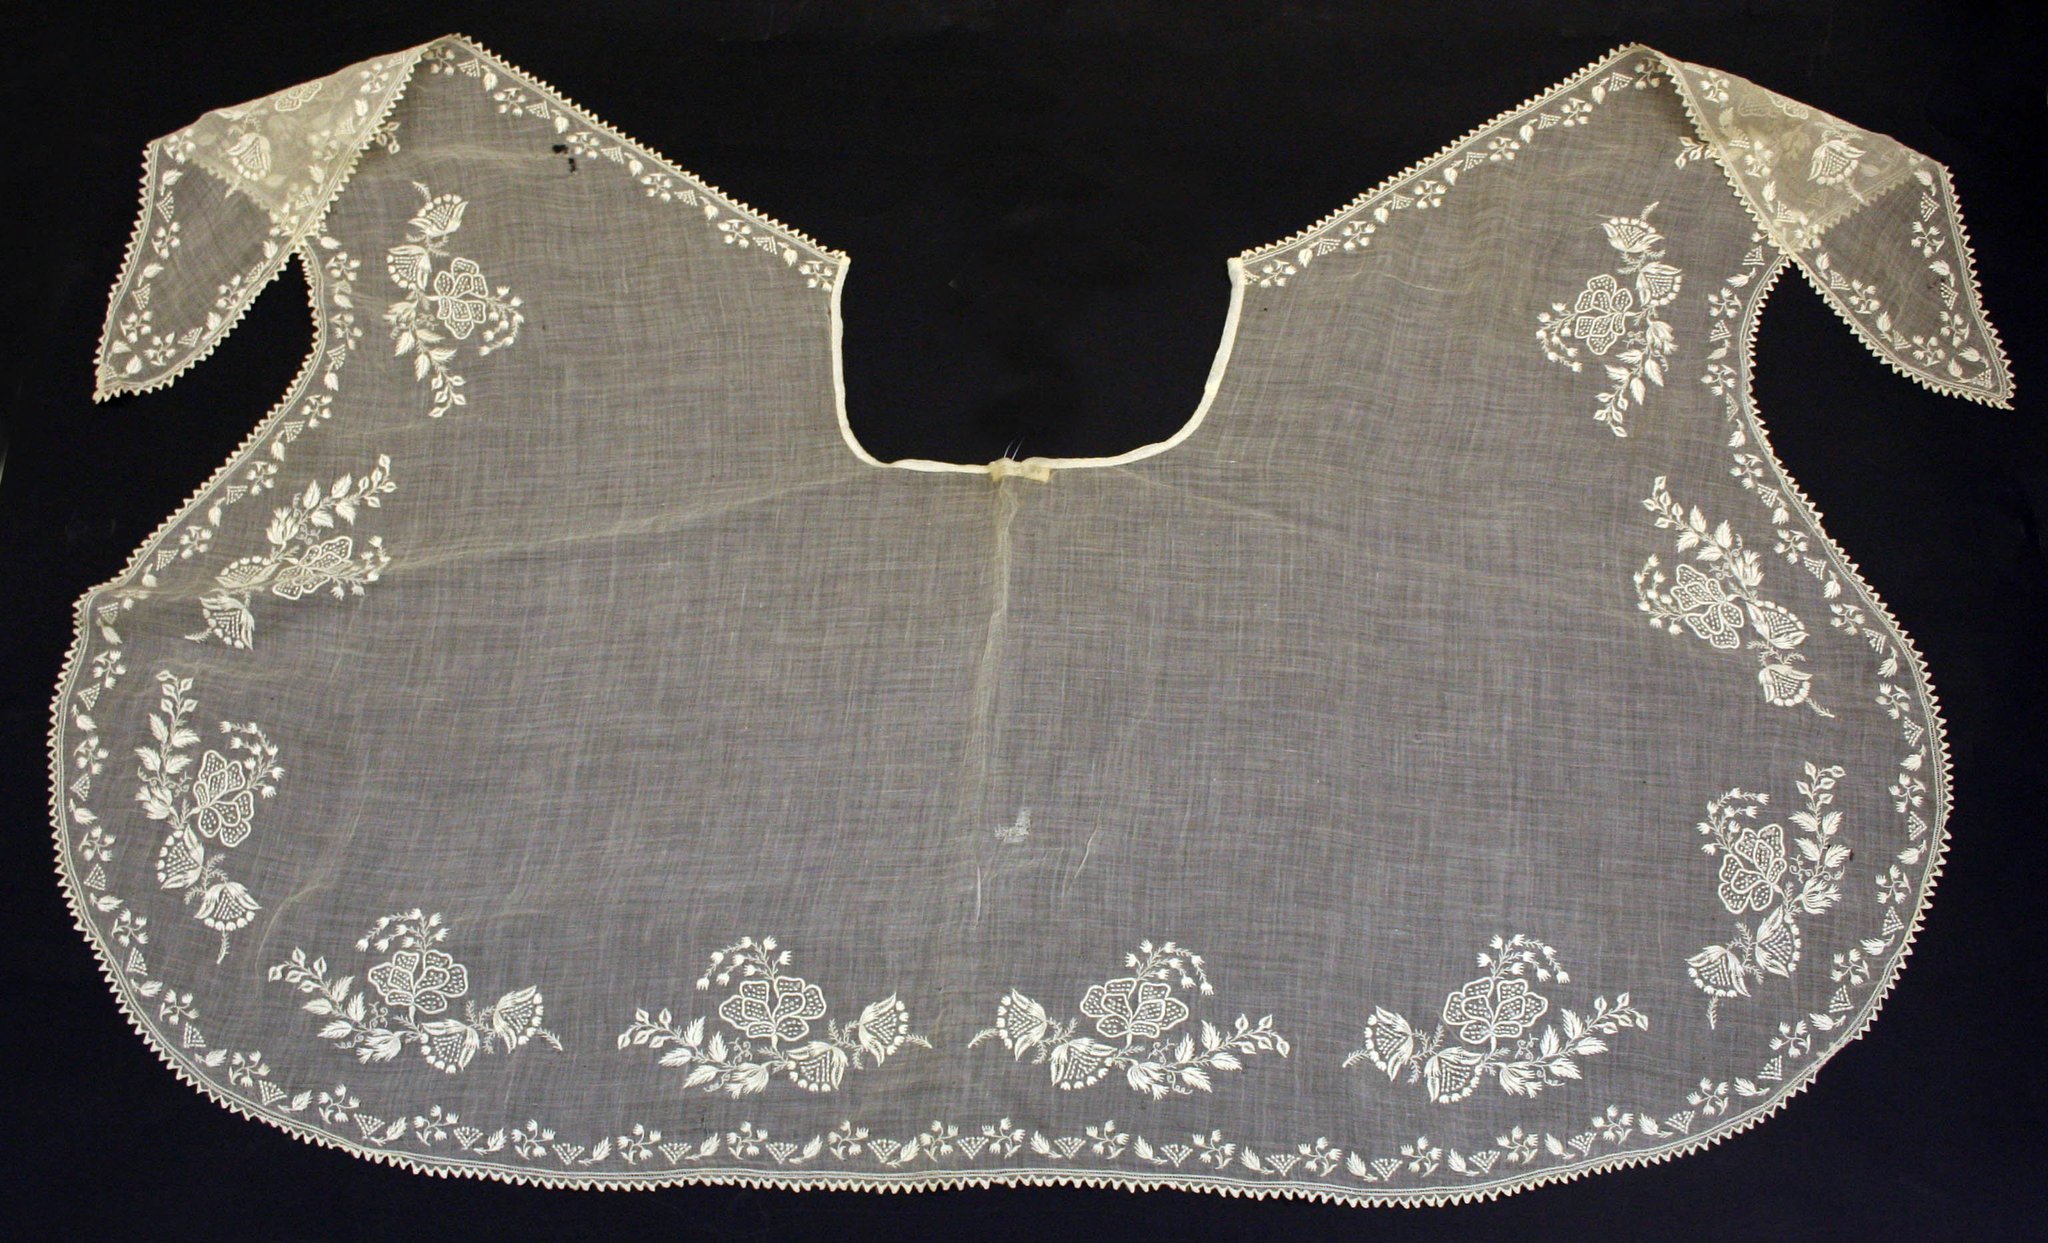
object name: fichu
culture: american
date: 1830-1840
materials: cotton